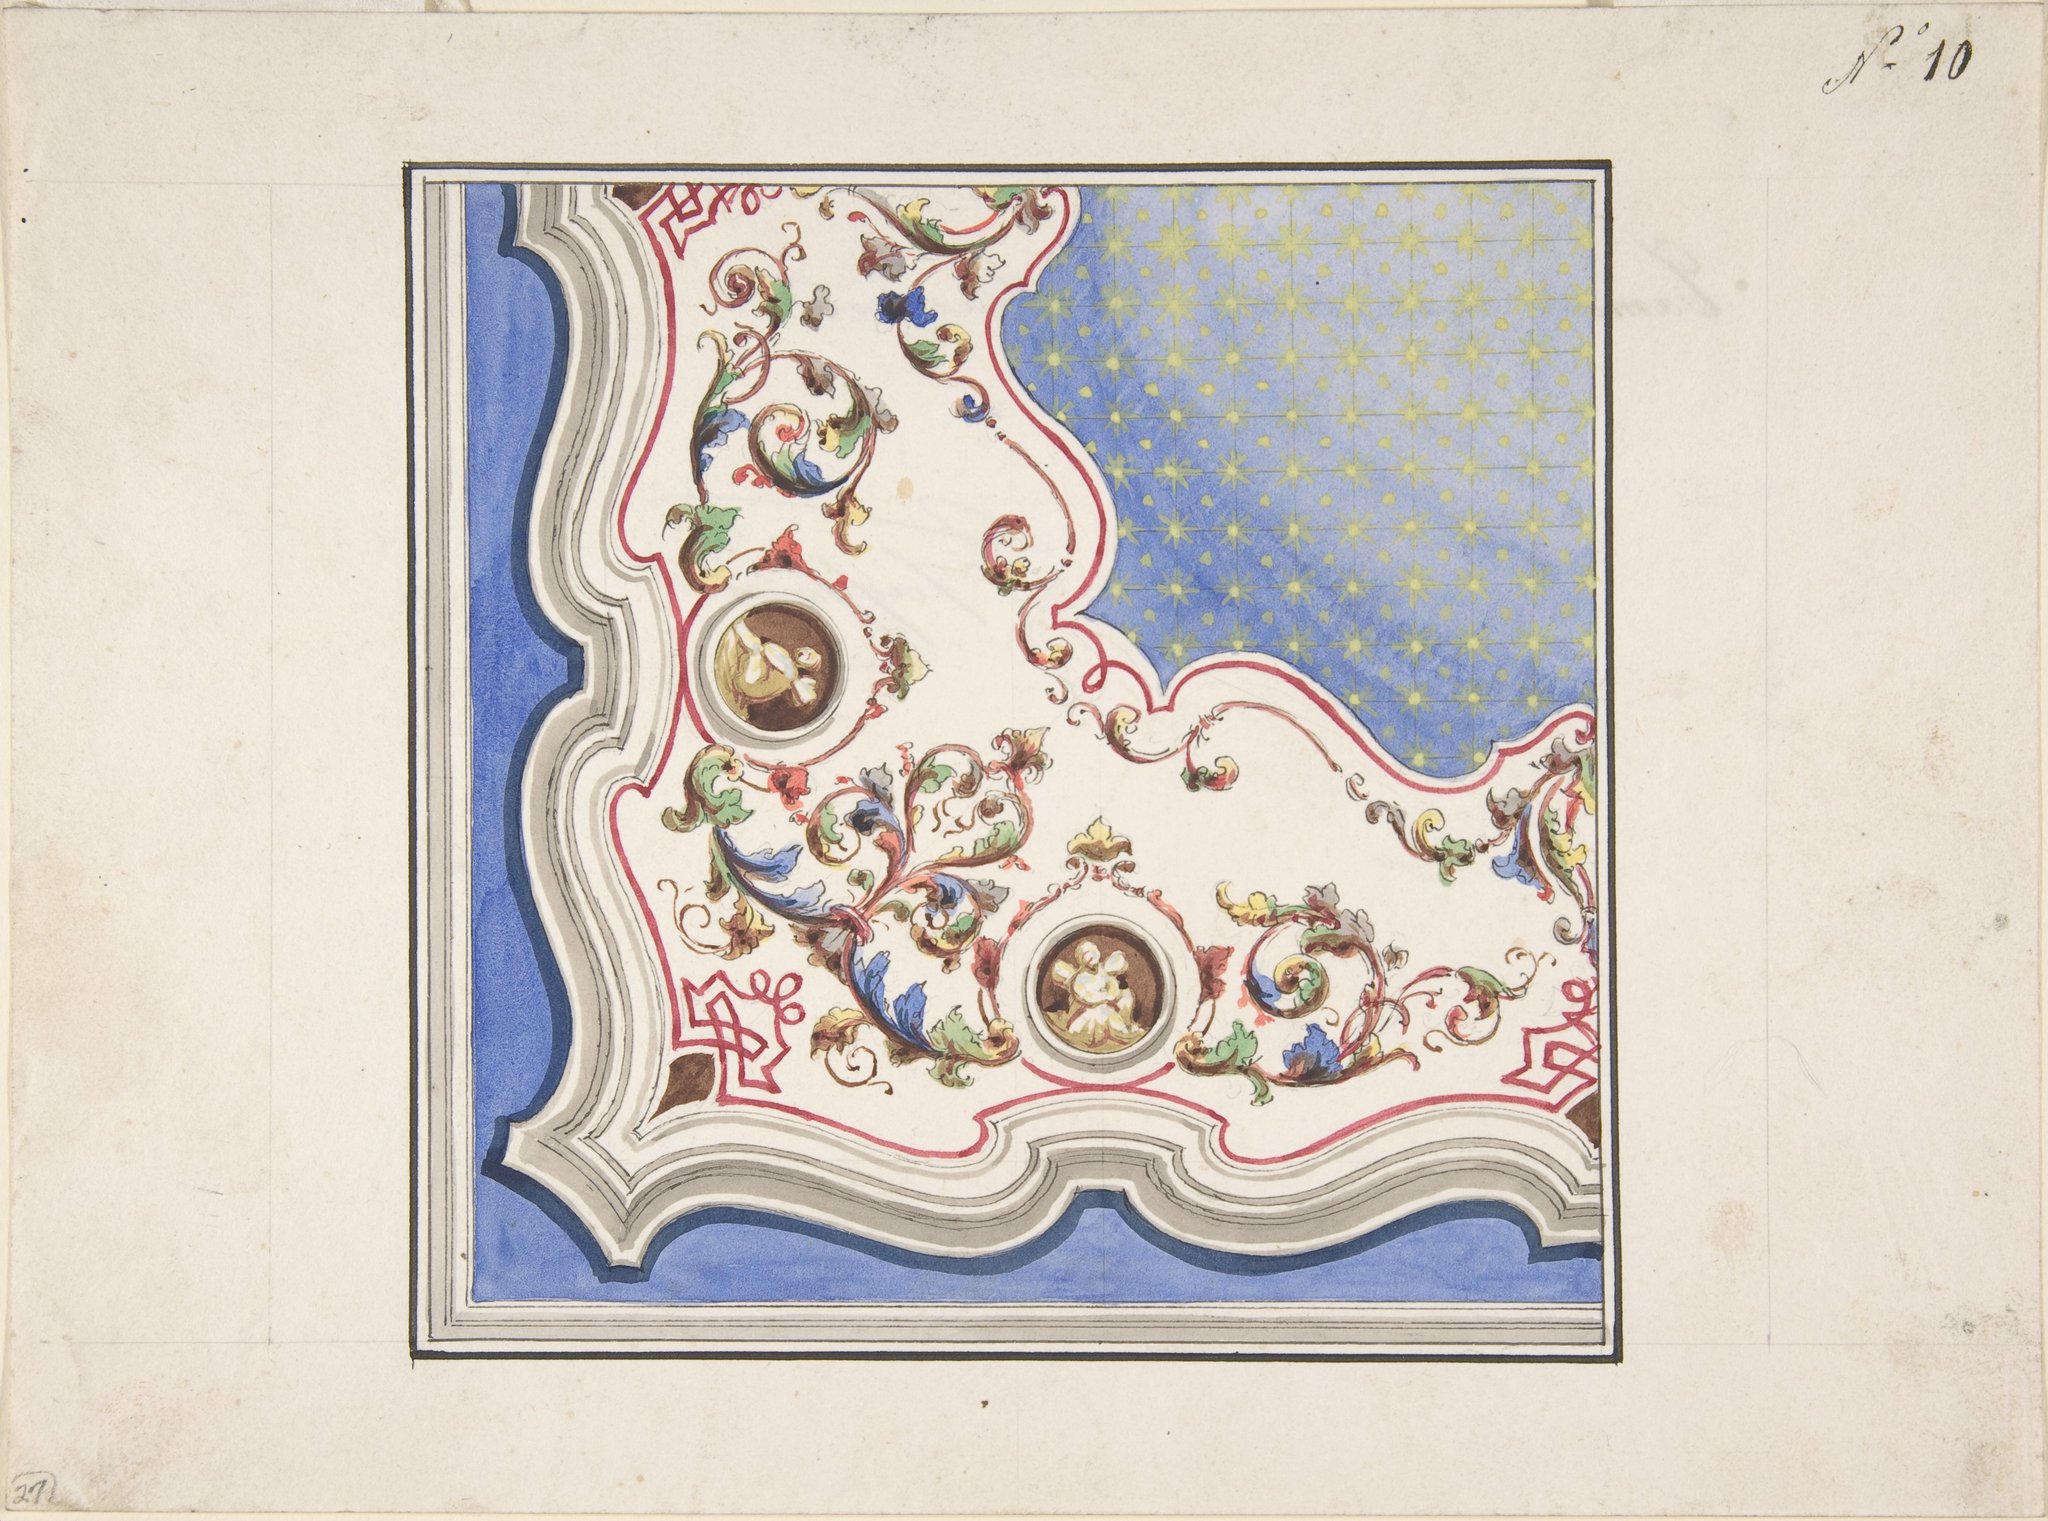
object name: drawing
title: Design for Ceiling Decoration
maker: anonymous, italian, 19th century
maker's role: artist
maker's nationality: italian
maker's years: 1800-1900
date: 1850-1870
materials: watercolor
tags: ceilings